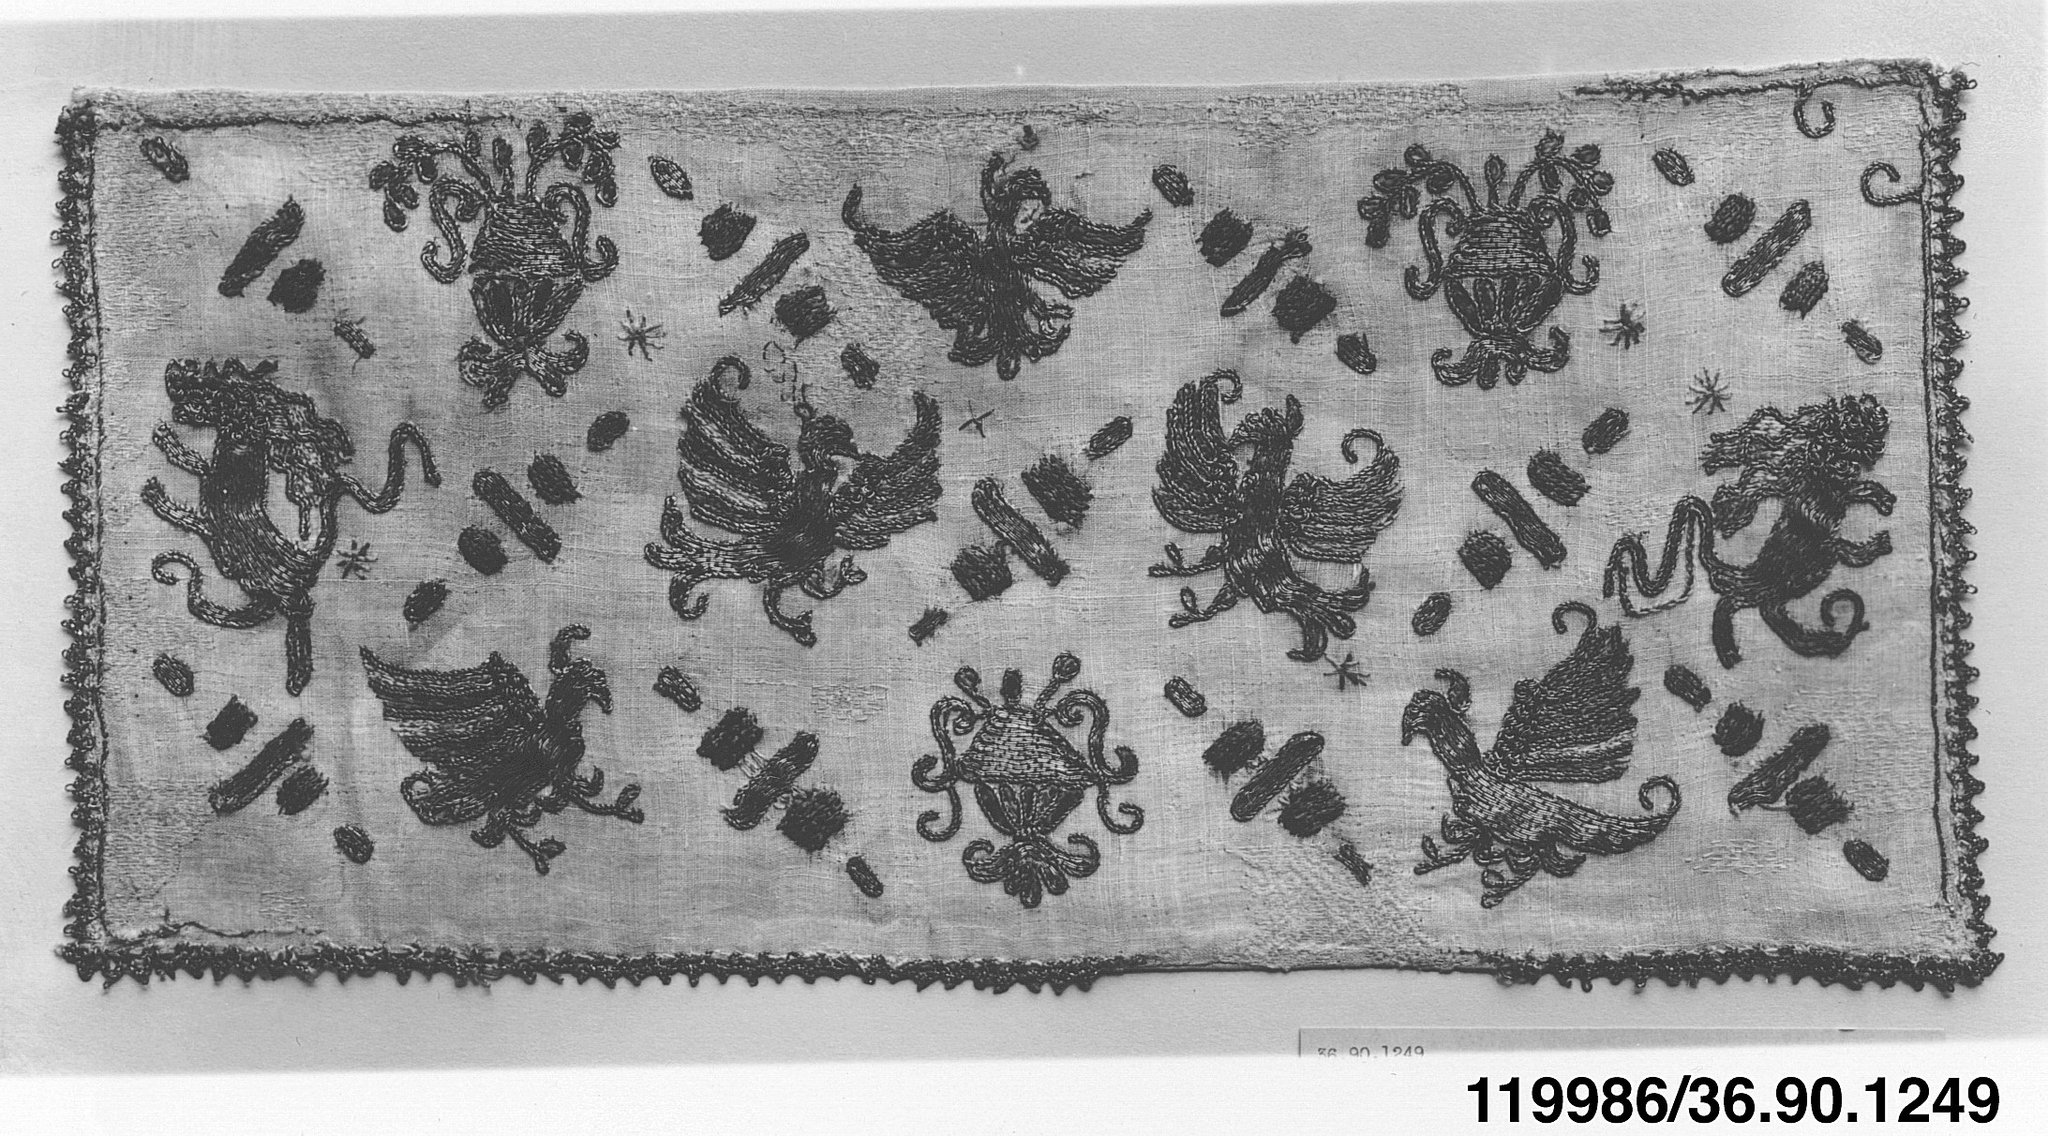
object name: band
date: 1501-1600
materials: linen, metal thread, silk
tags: birds